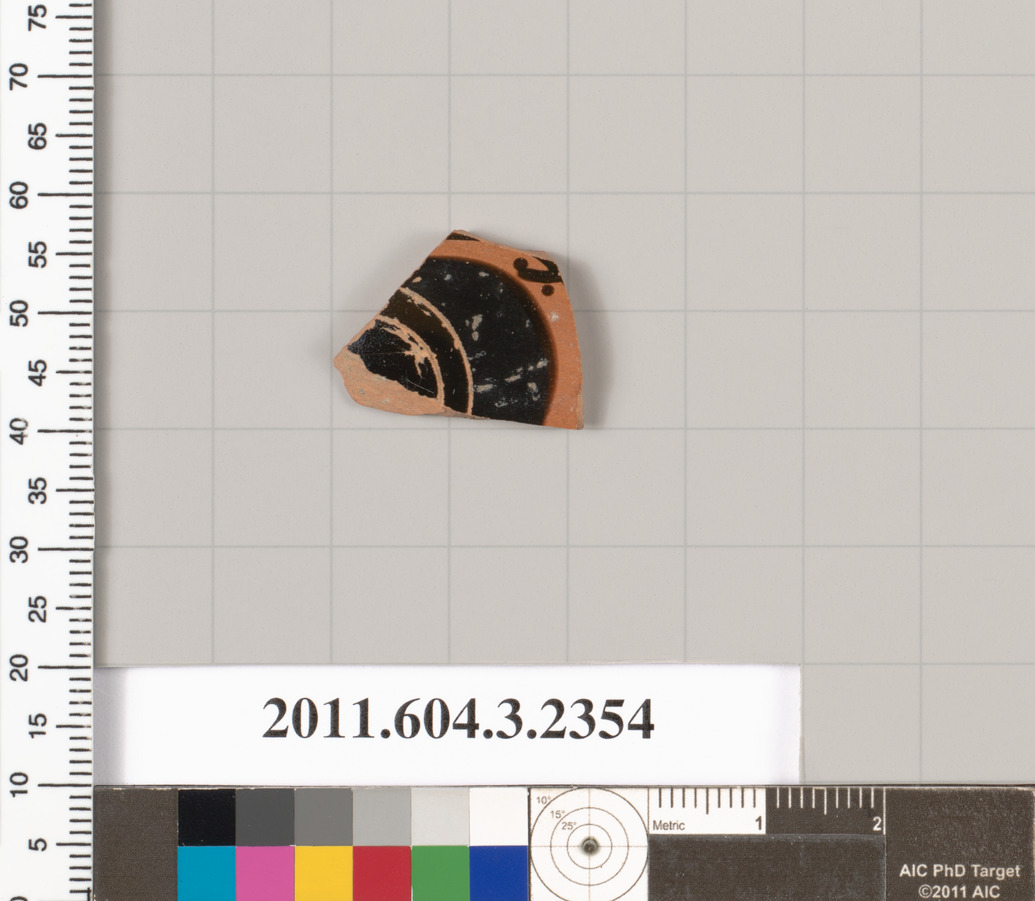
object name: kylix fragment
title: Terracotta fragment of a kylix: eye-cup (drinking cup)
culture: greek, attic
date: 530-510 BCE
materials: terracotta